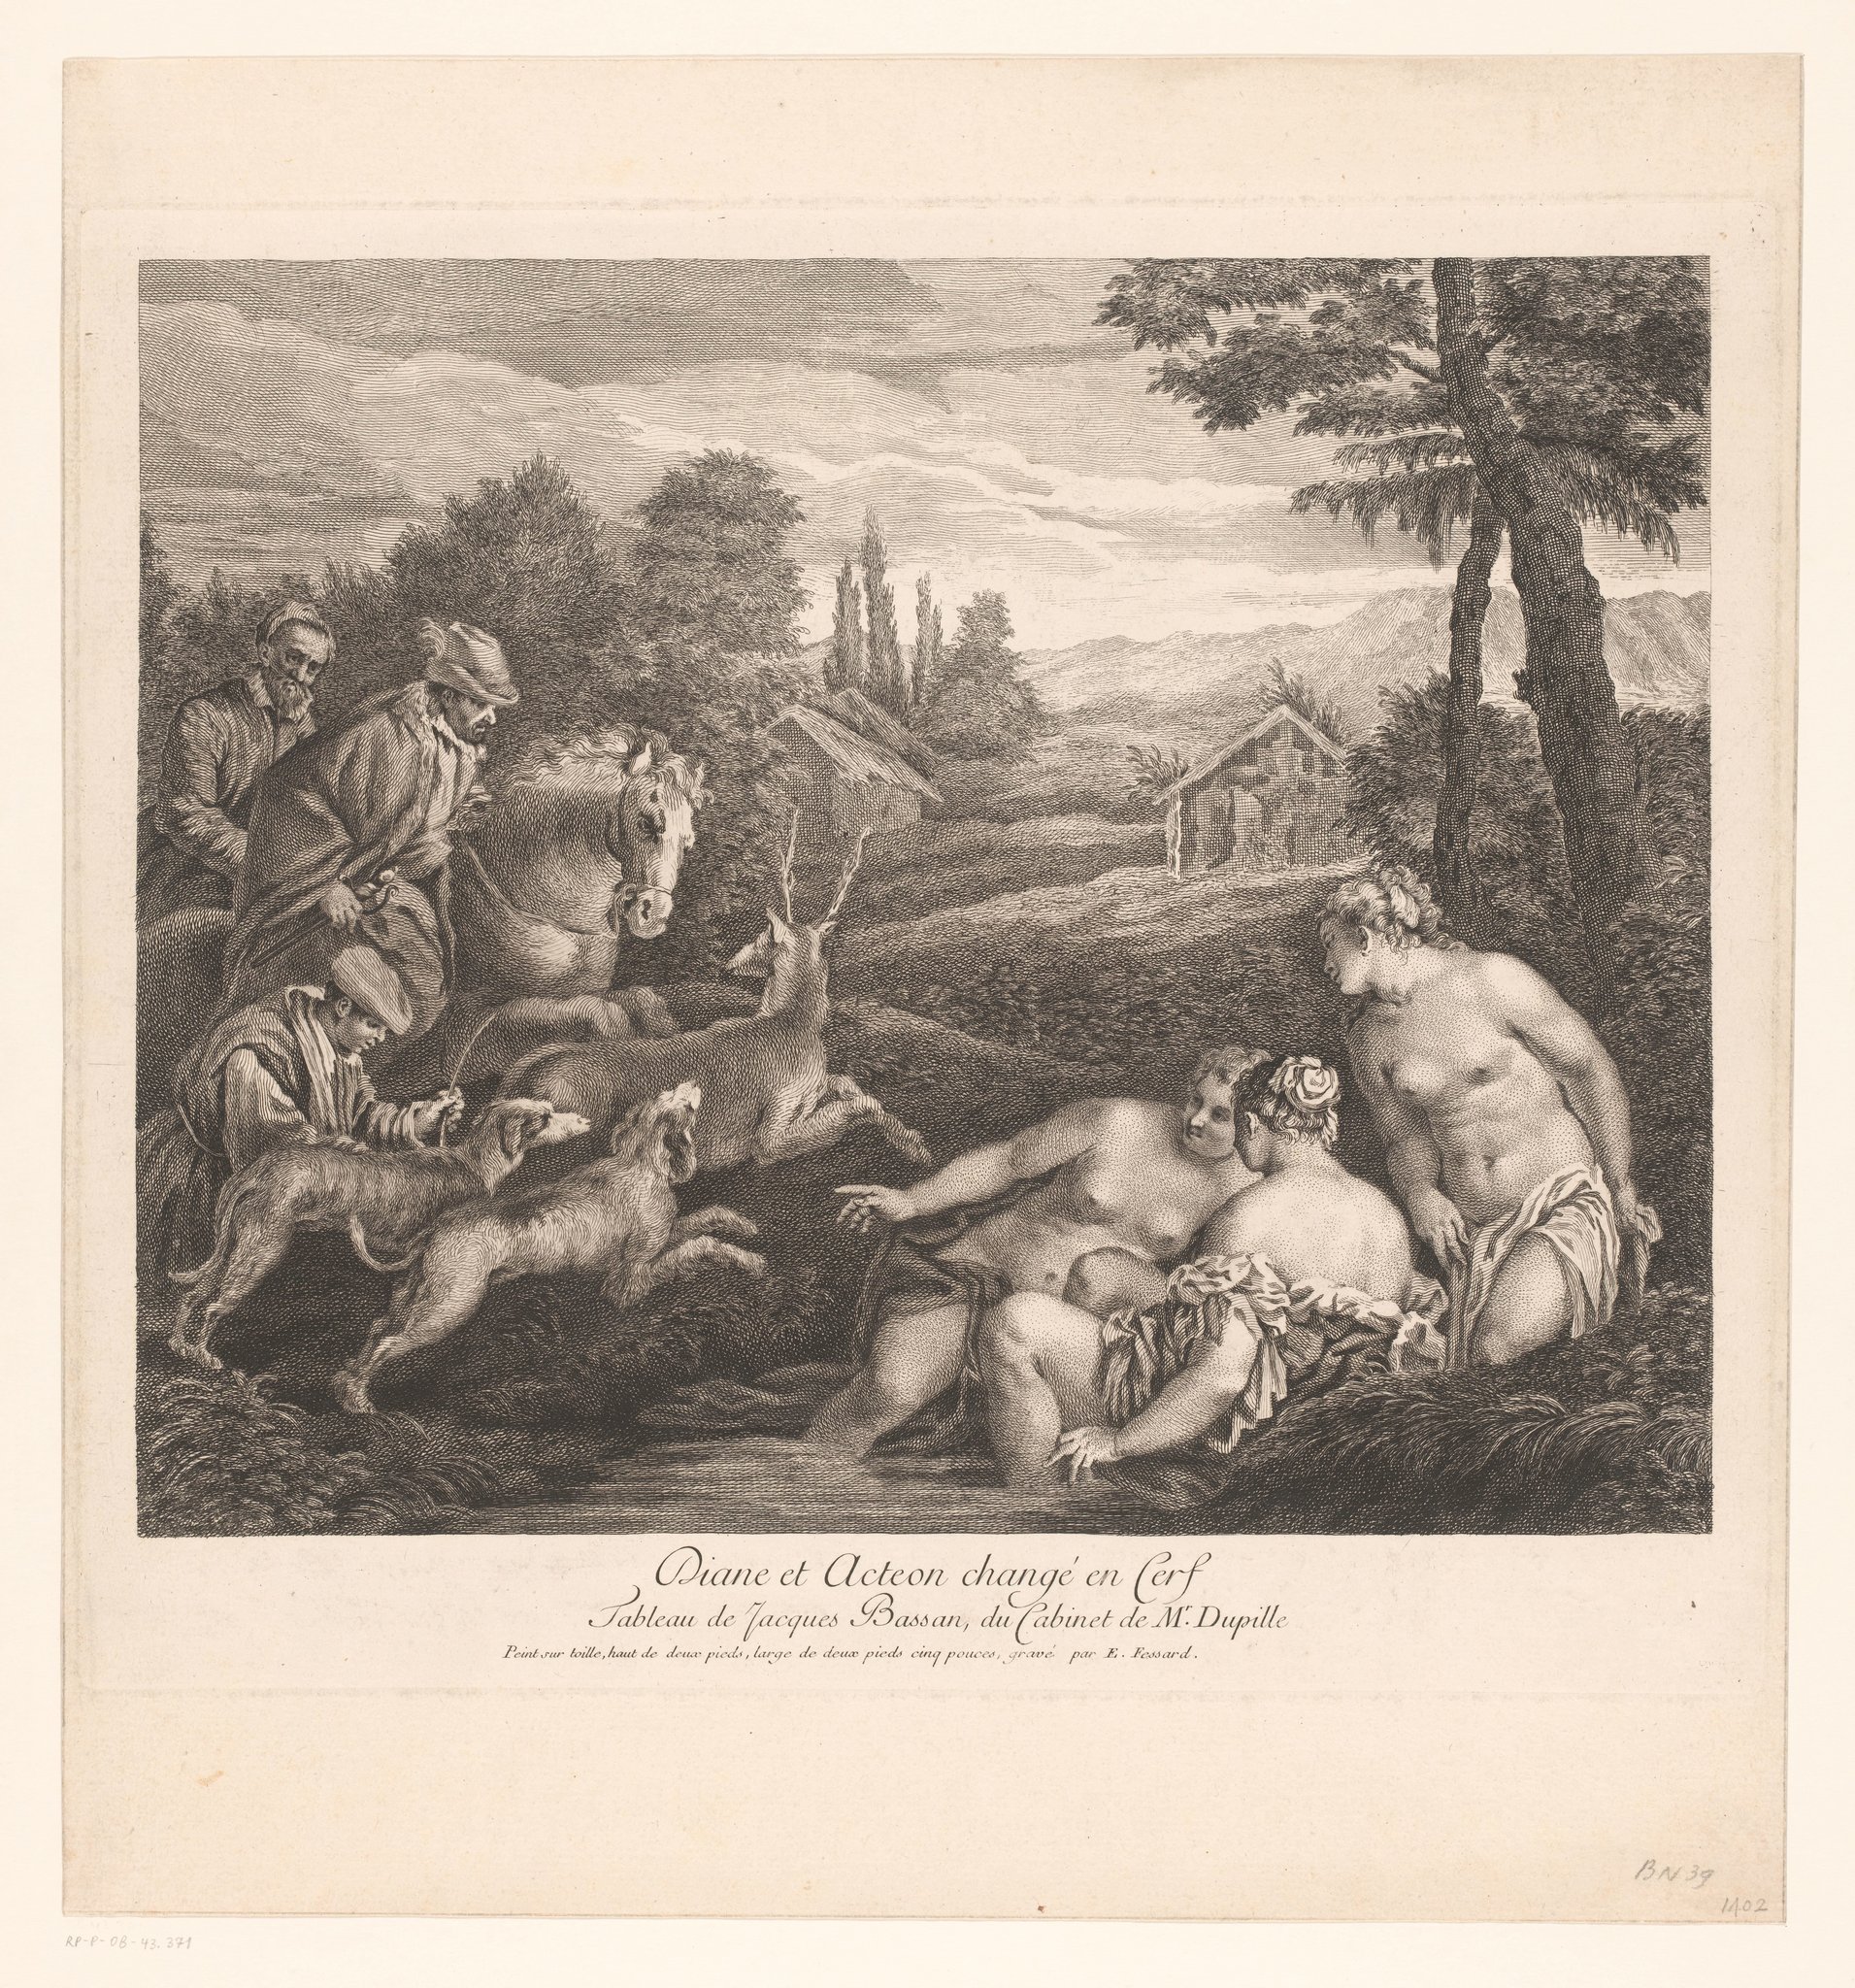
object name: print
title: Diane et Acteon changé en Cerf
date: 1742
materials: paper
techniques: engraving, etching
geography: france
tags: actaeon changed into a stag: as punishment for seeing her bathe, diana changes actaeon, the hunter, into a stag (ovid, metamorphoses iii 193)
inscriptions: collector's mark: Lugt 240